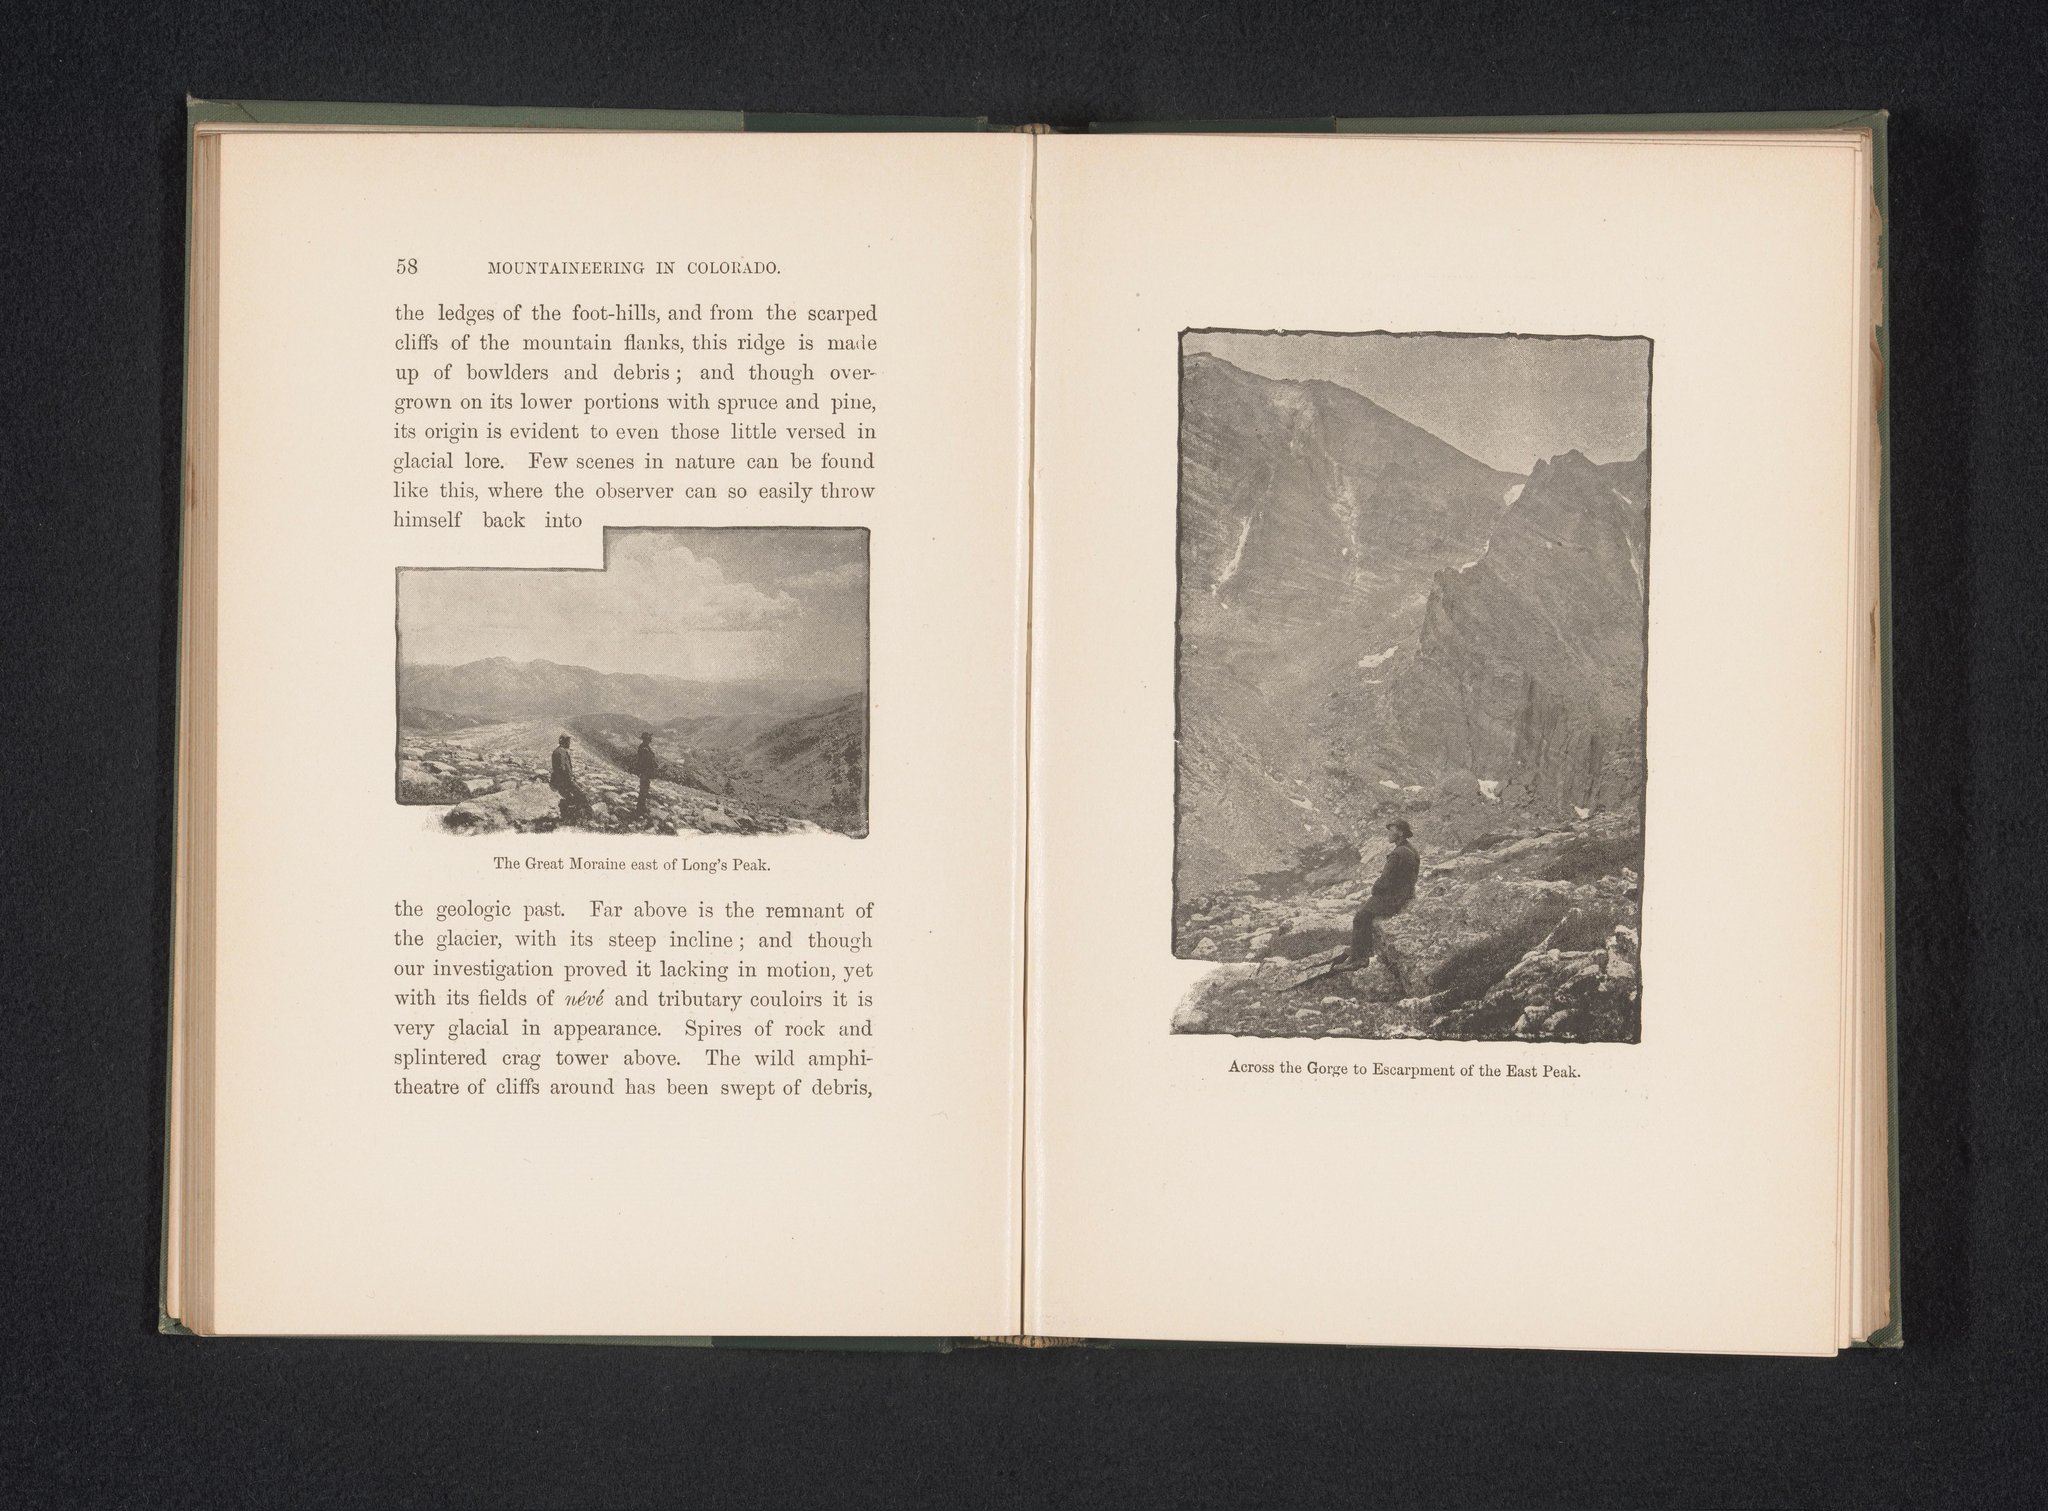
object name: page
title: Across the Gorge to Esarptment of the East peak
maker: frederick hastings chapin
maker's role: antropoloog, archeoloog, fotograaf, schrijver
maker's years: 1852-1900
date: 1885-1890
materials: paper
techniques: autotype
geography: longs peak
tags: wildlife reserve, national park, historical persons, mountains